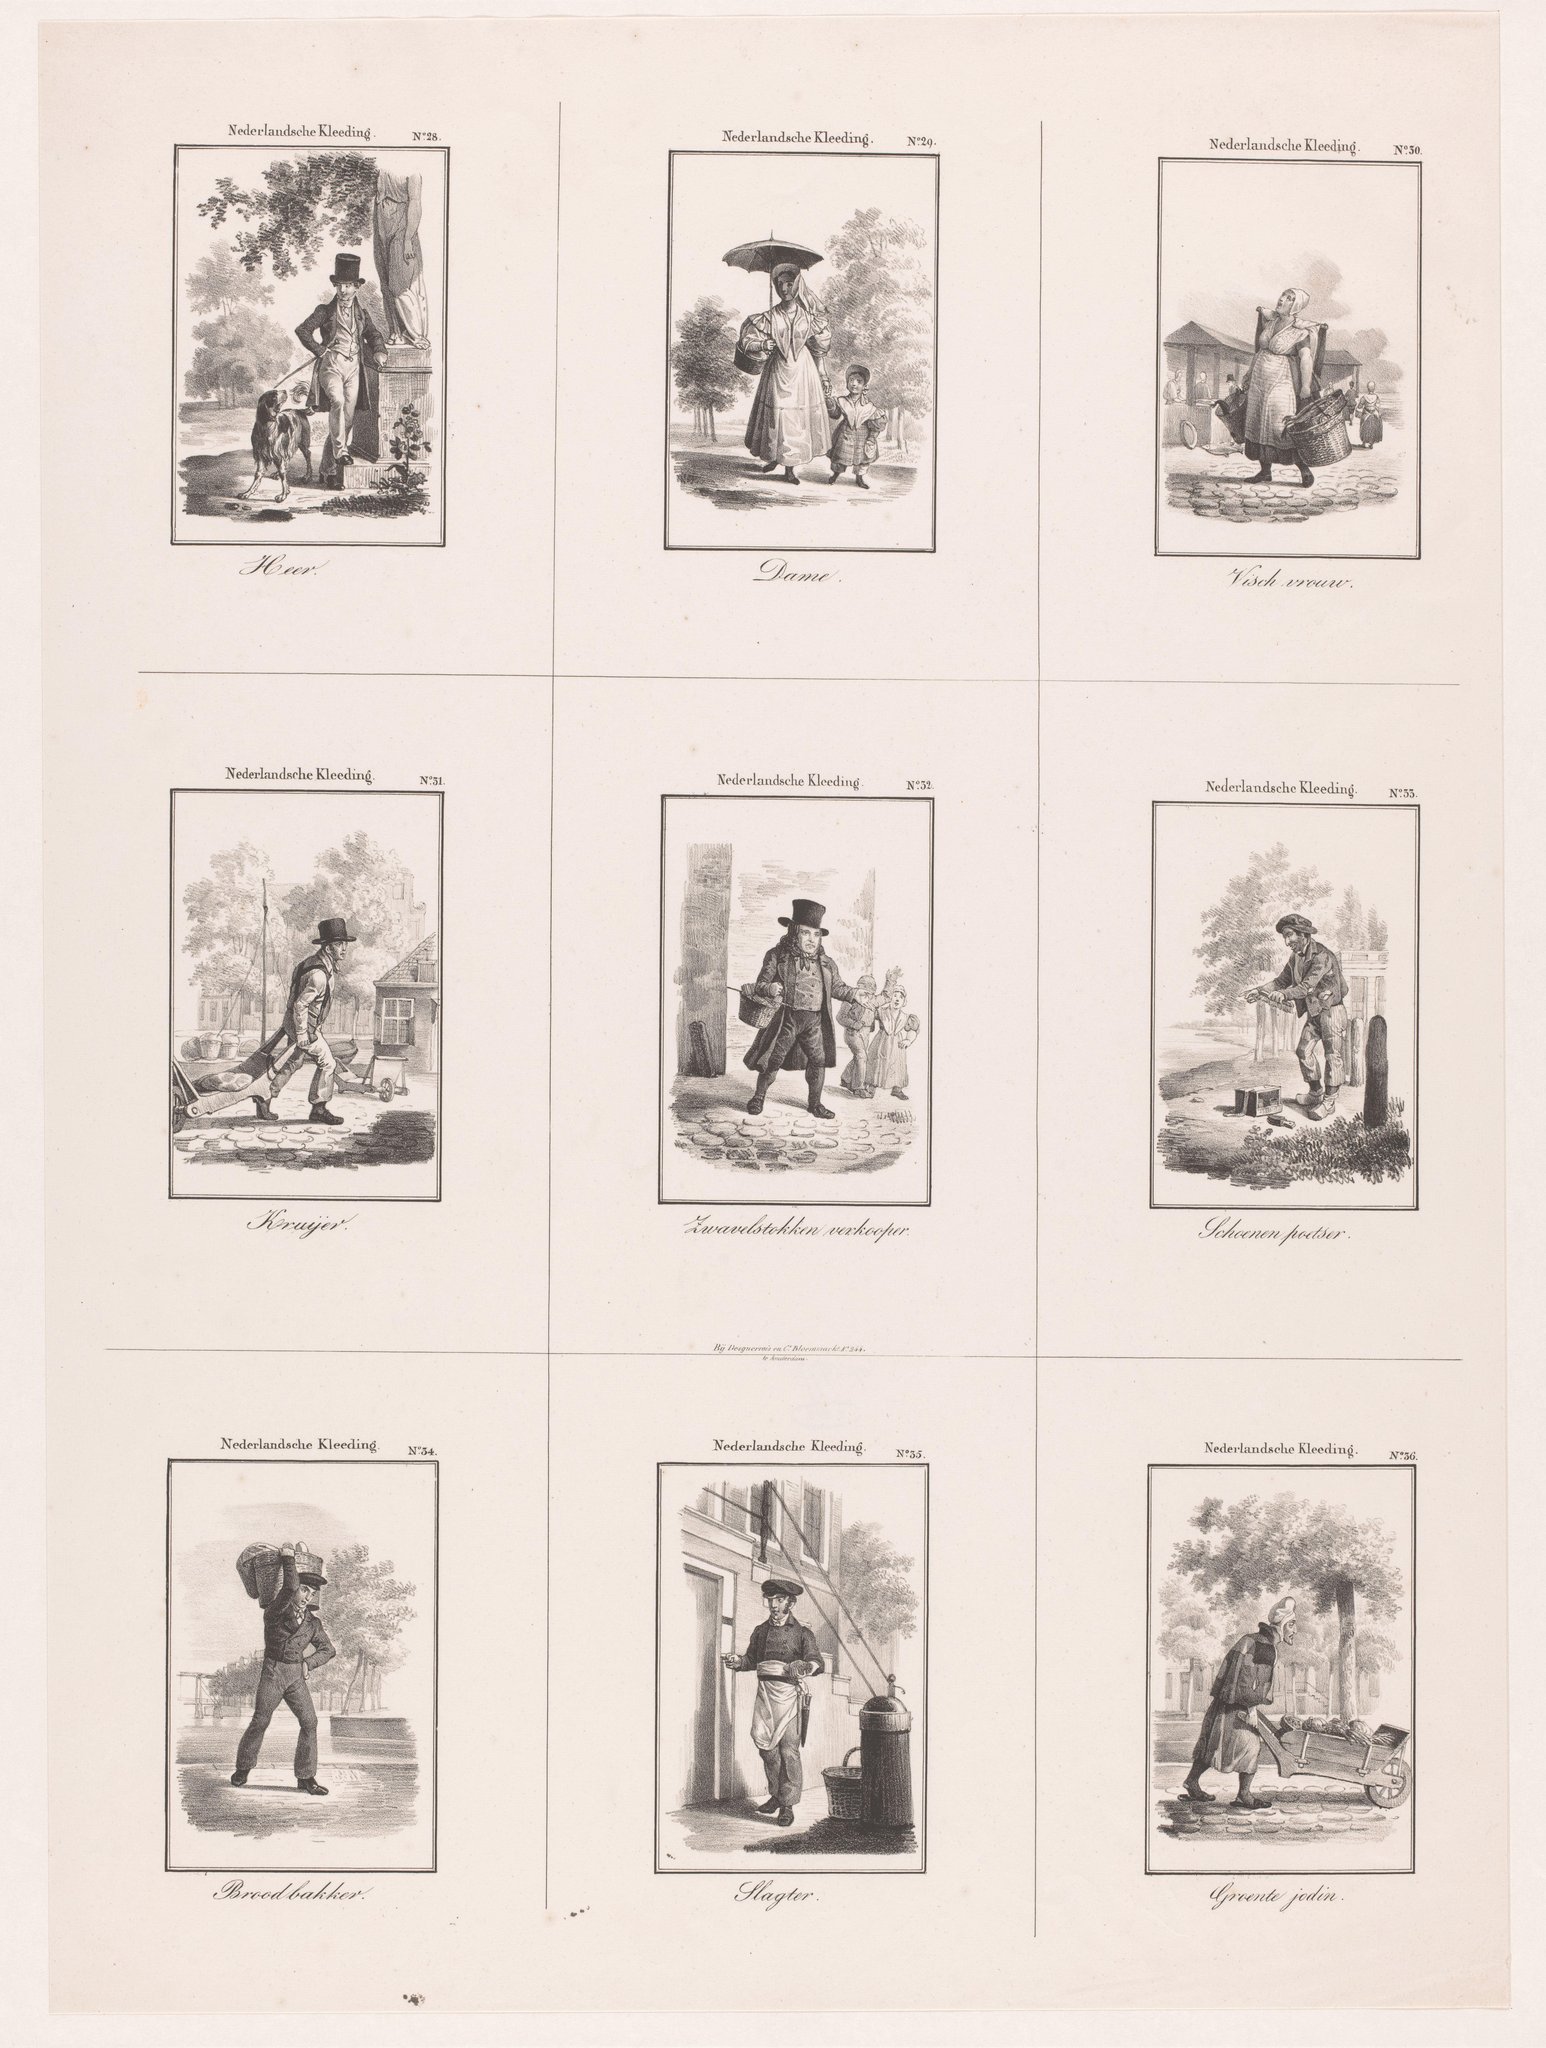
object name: print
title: Kleding van de Nederlandse burgers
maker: Anonymous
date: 1827-1907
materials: paper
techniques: lithograph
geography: amsterdam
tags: commoners, clothes, costume, villagers; villeins (dutch: 'dorpers')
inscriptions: collector's mark: Lugt 2228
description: Afgebeeld zijn negen figuren: een heer, een dame, een visvrouw, een kruier, een zwavelstokkenverkoper, een schoenpoetser, een bakker, een slager en een groentevrouw. Alle voorstellingen zijn genummerd. Onder iedere figuur staat diens beroep. De reeks bevat in ieder geval 36 voorstellingen.